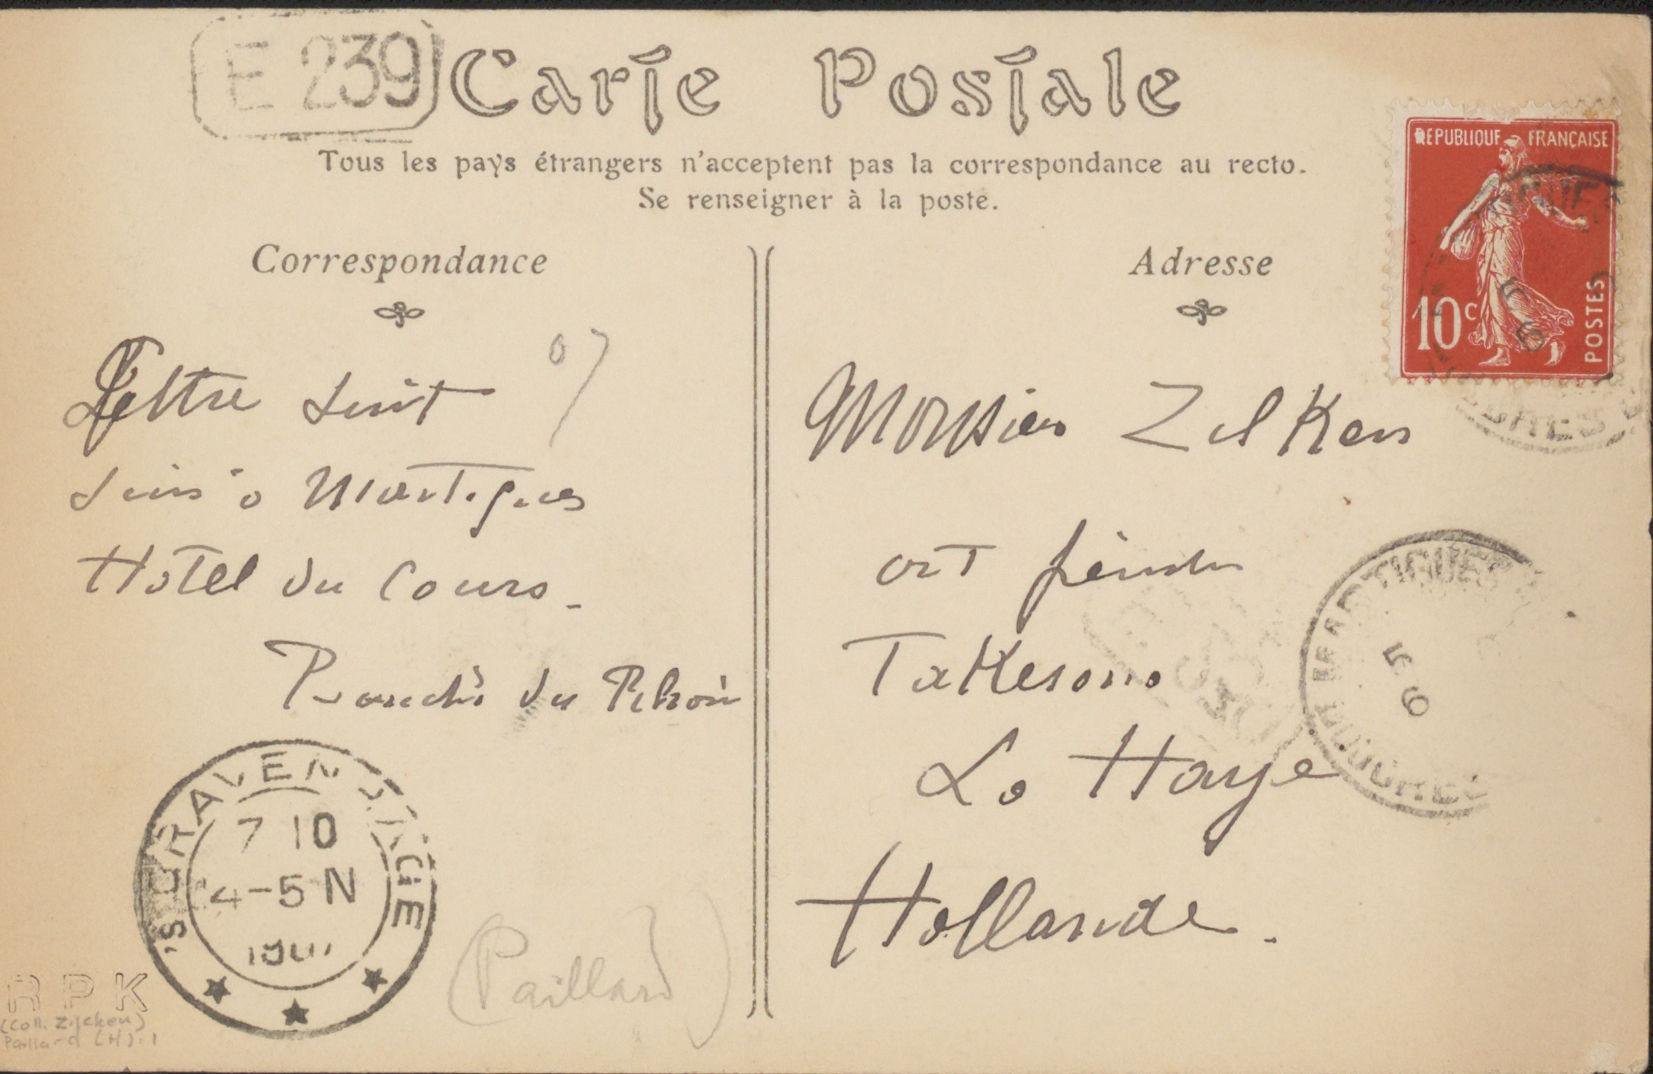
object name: ansichtkaart, prentbriefkaart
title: Prentbriefkaart aan Philip Zilcken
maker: henri pierre paillard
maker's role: painter, print maker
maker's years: 1844-1912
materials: cardboard, ink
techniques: photograph, pen, writing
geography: martigues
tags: painter, draughtsman, philip zilcken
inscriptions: collector's mark: ‘RPK’